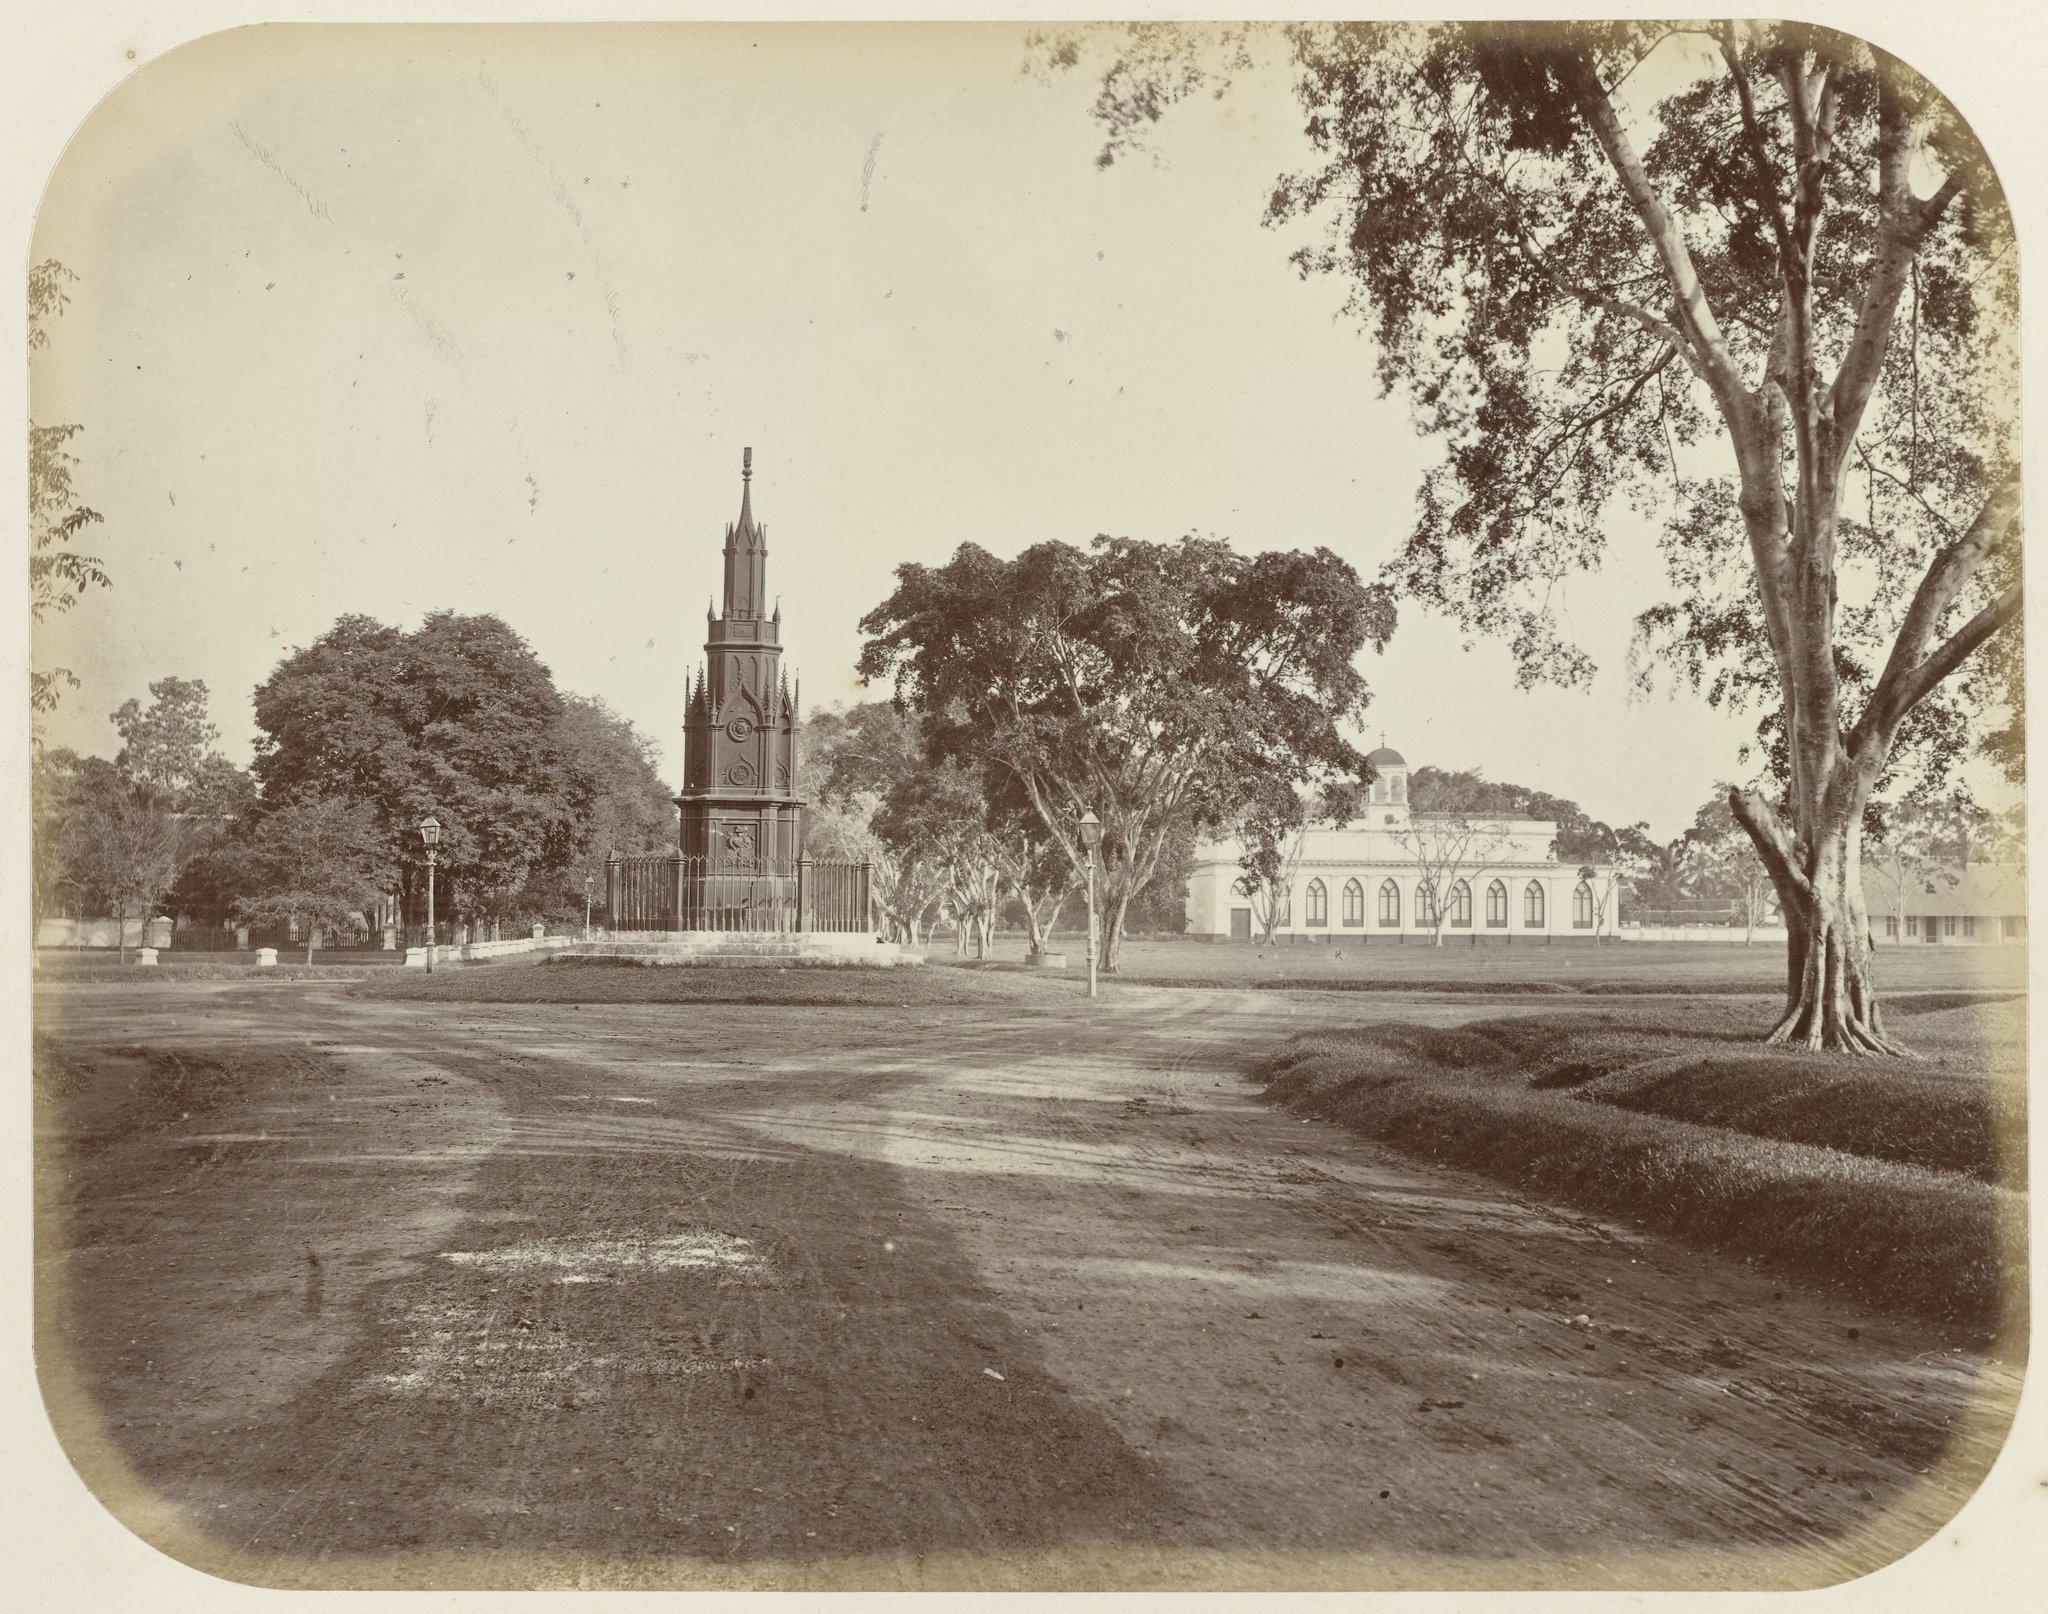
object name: photograph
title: Memorial to General Andreas Victor Michiels in Waterlooplein in Batavia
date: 1870-1890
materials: photographic support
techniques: albumen print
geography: batavia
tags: landscape with monument, public road, java, batavia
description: Gezicht op het Michielsmonument op het Waterlooplein te Batavia. Ingeplakte foto in het fotoalbum getiteld: Gezichten van Java.